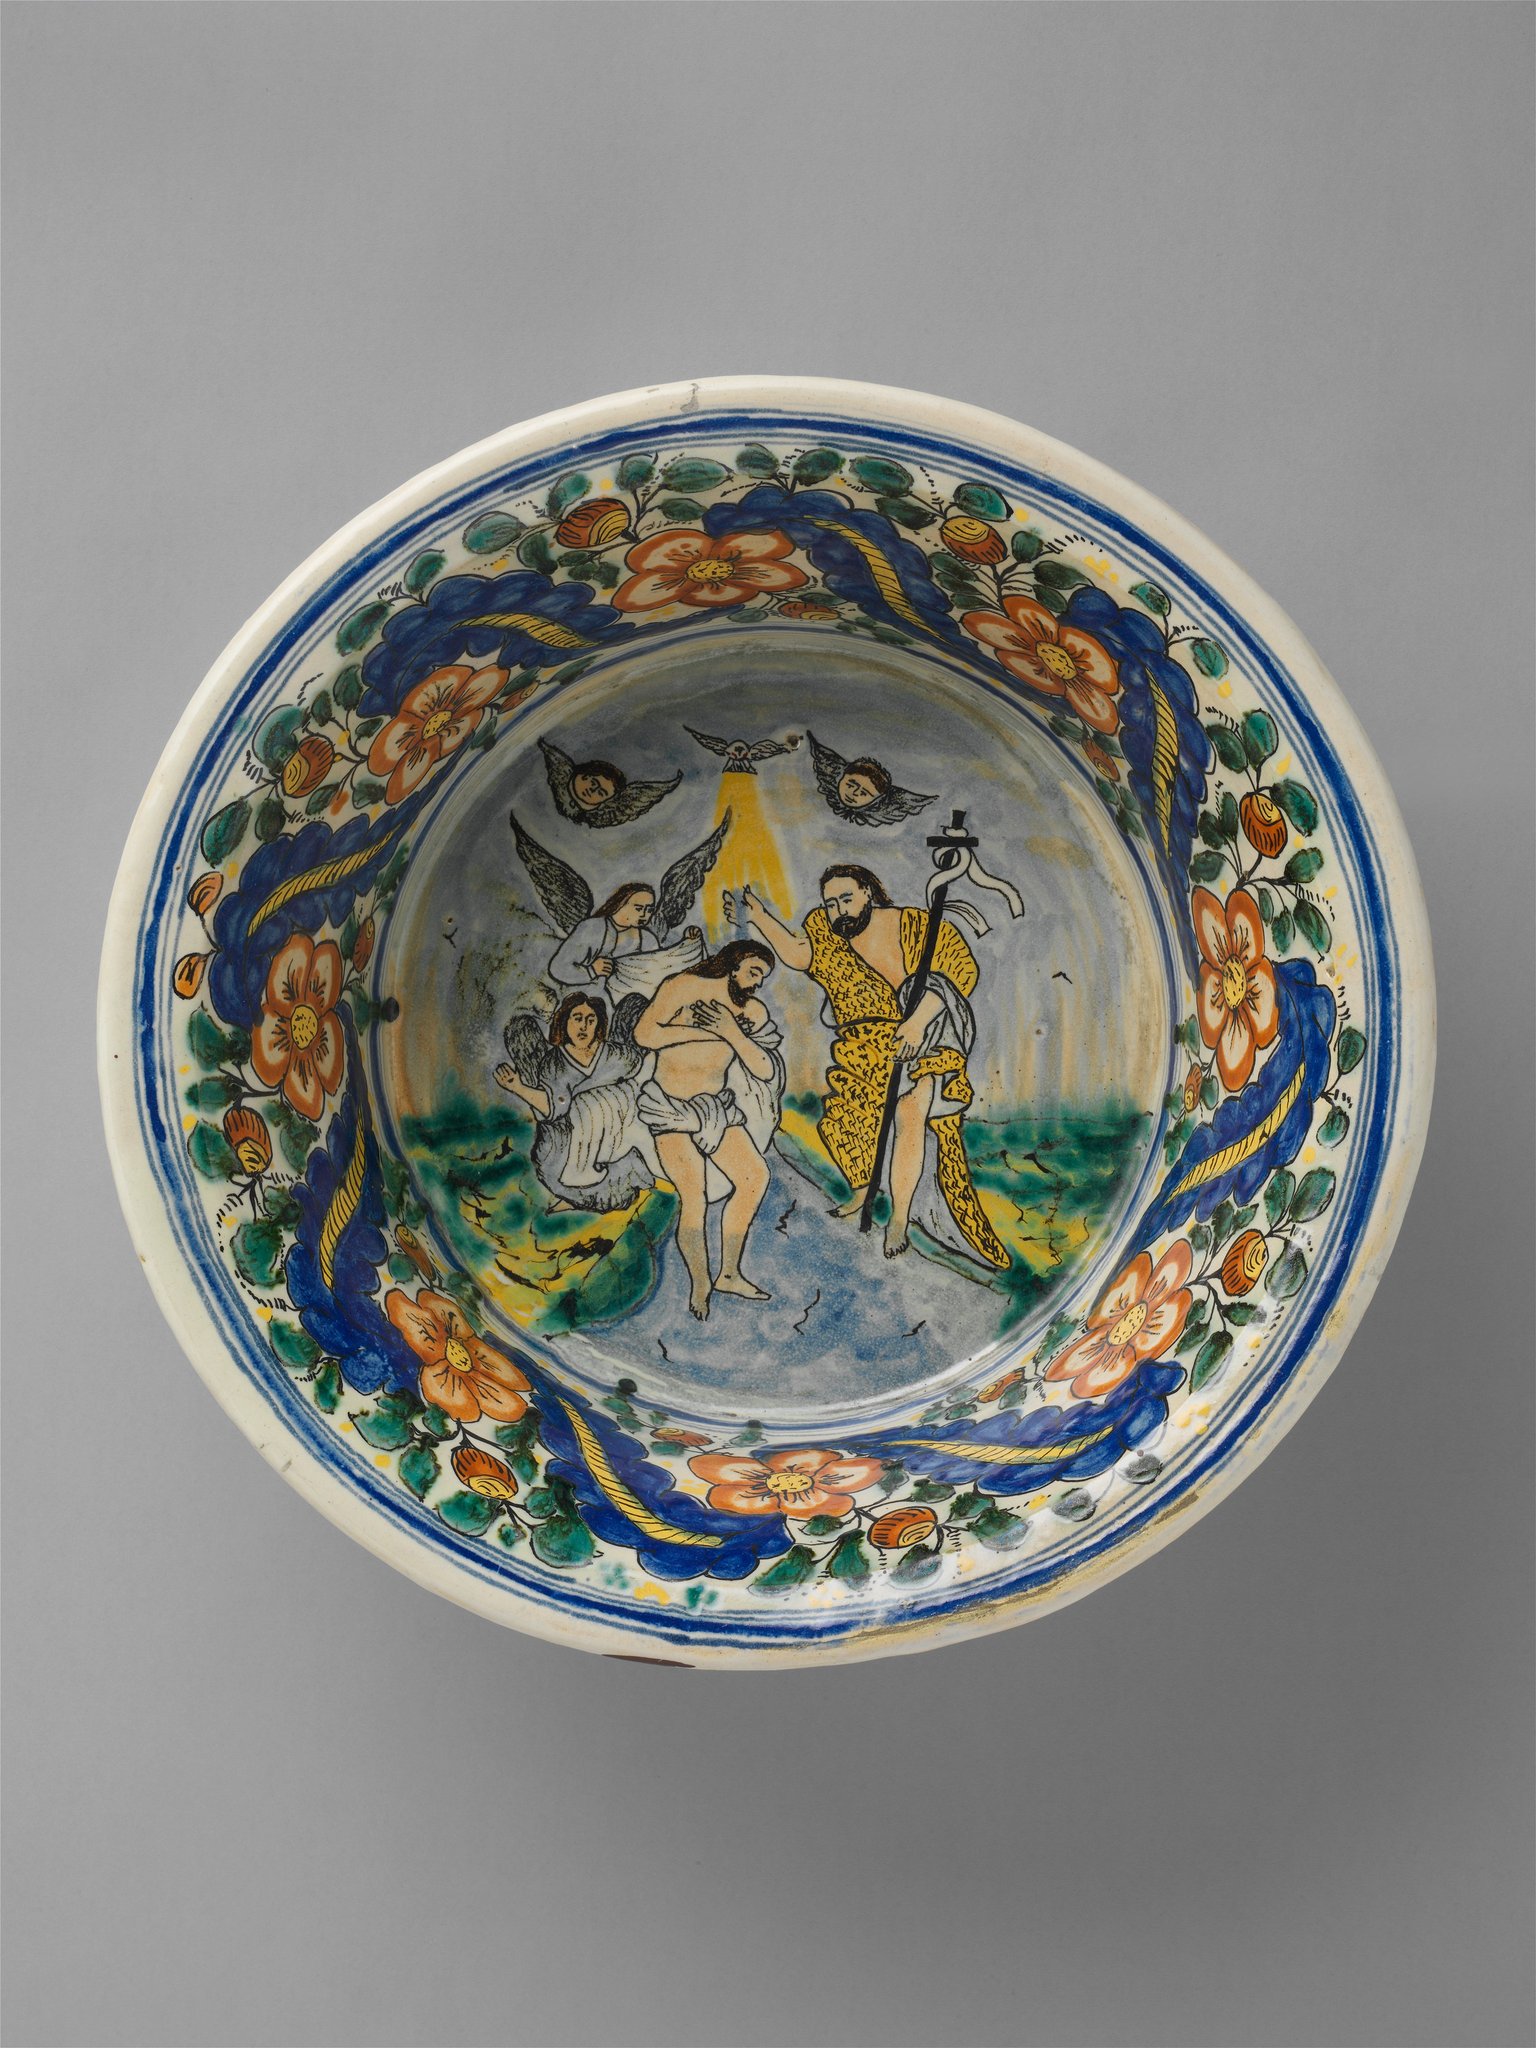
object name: baptismal basin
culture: mexican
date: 1875-1900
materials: earthenware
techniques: glazing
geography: mexico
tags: angels,christ,baptism of christ